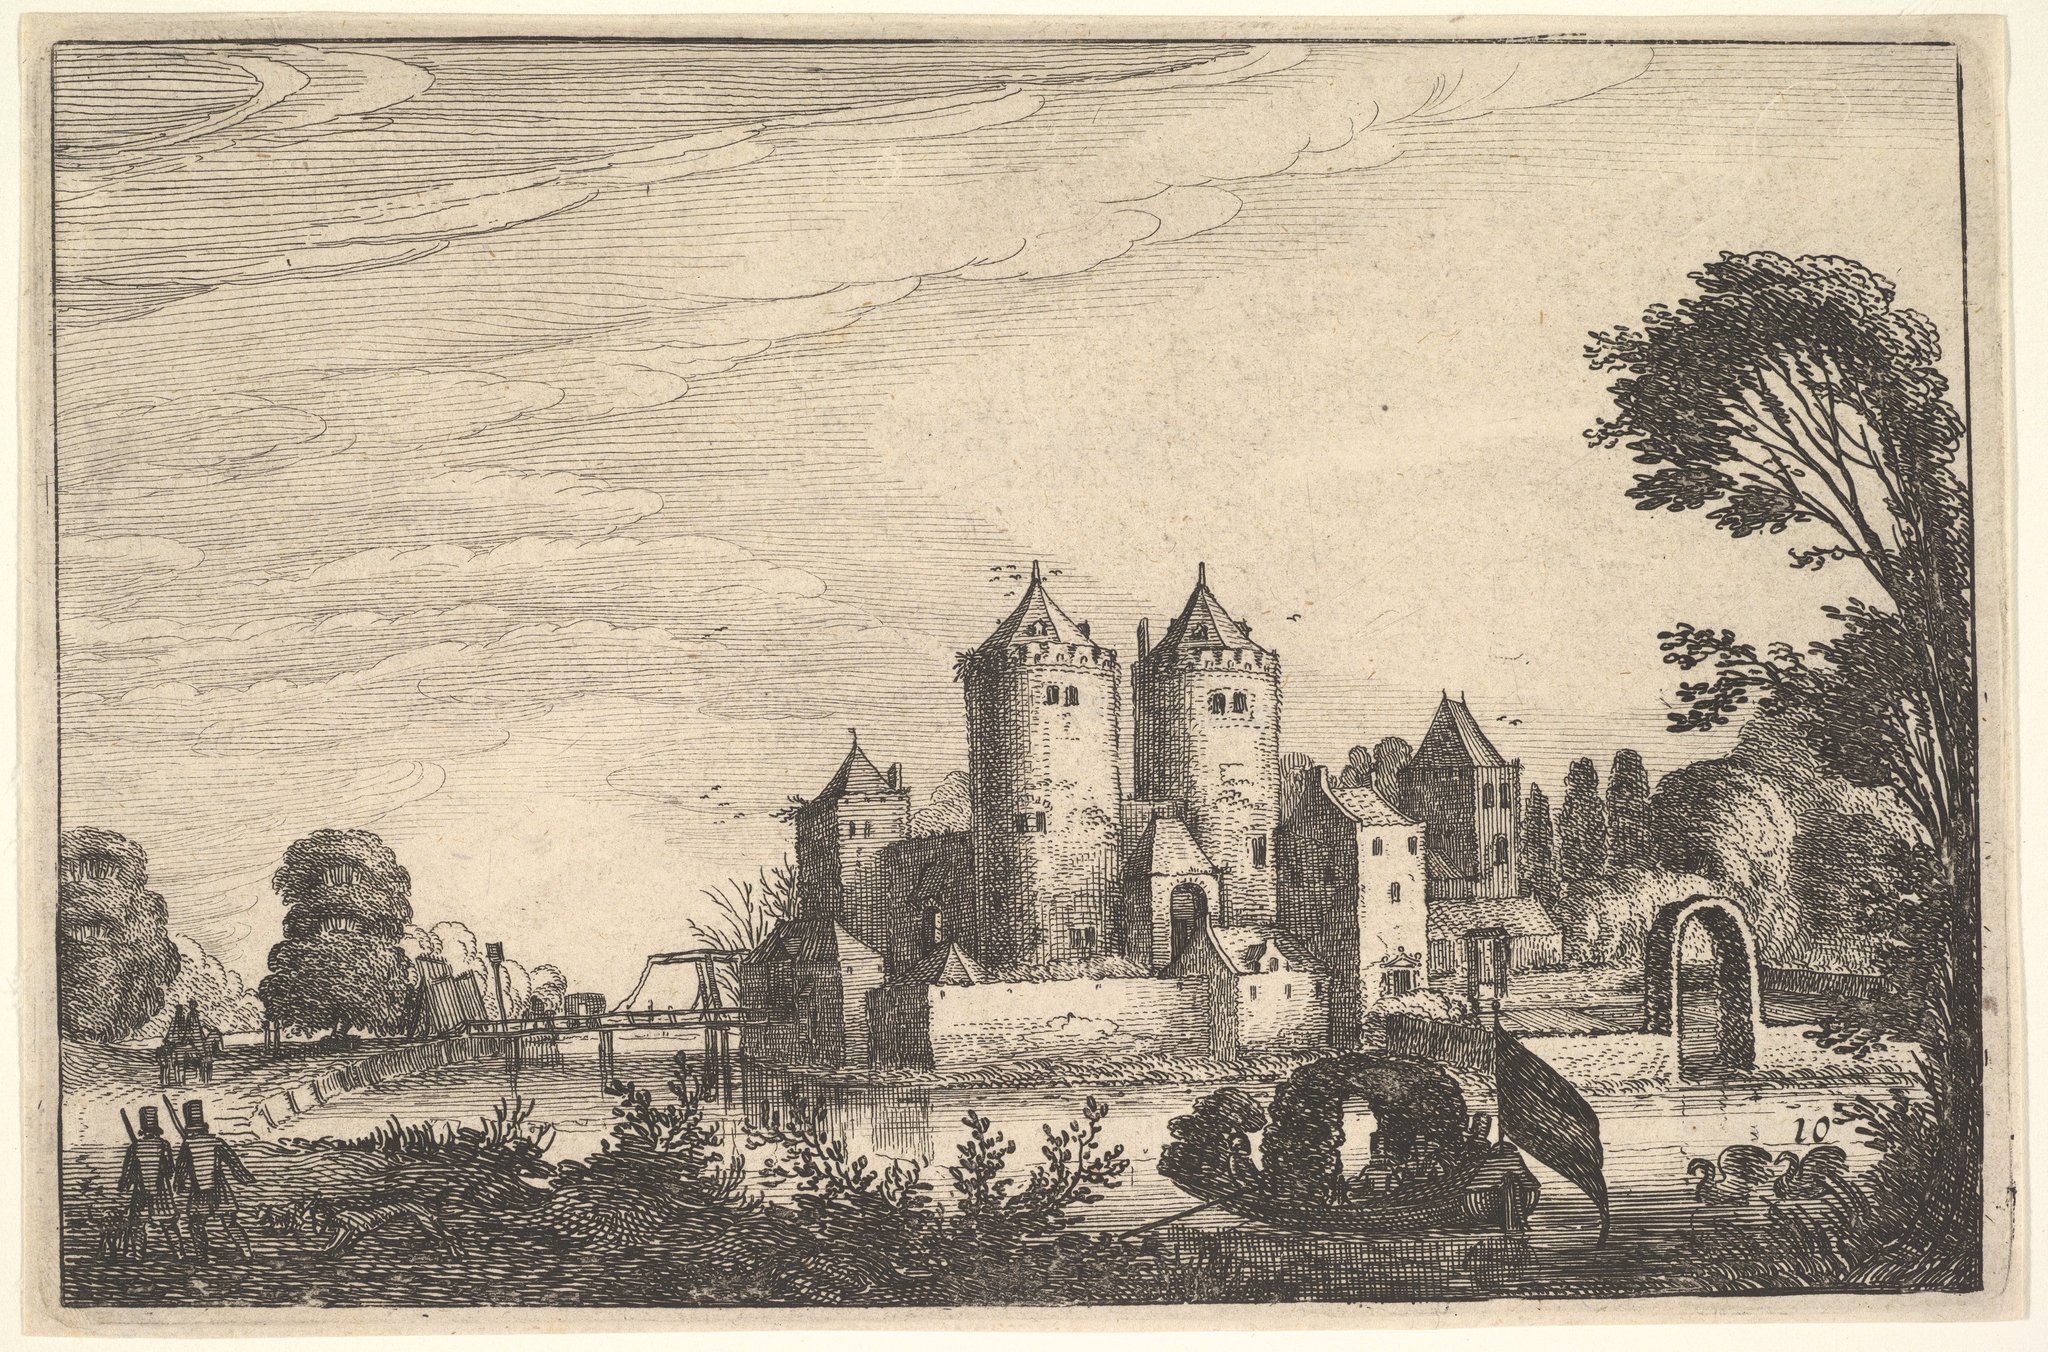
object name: print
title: The Castle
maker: jan van de velde ii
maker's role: artist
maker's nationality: dutch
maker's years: 1593-1641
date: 1616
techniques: etching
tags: castles